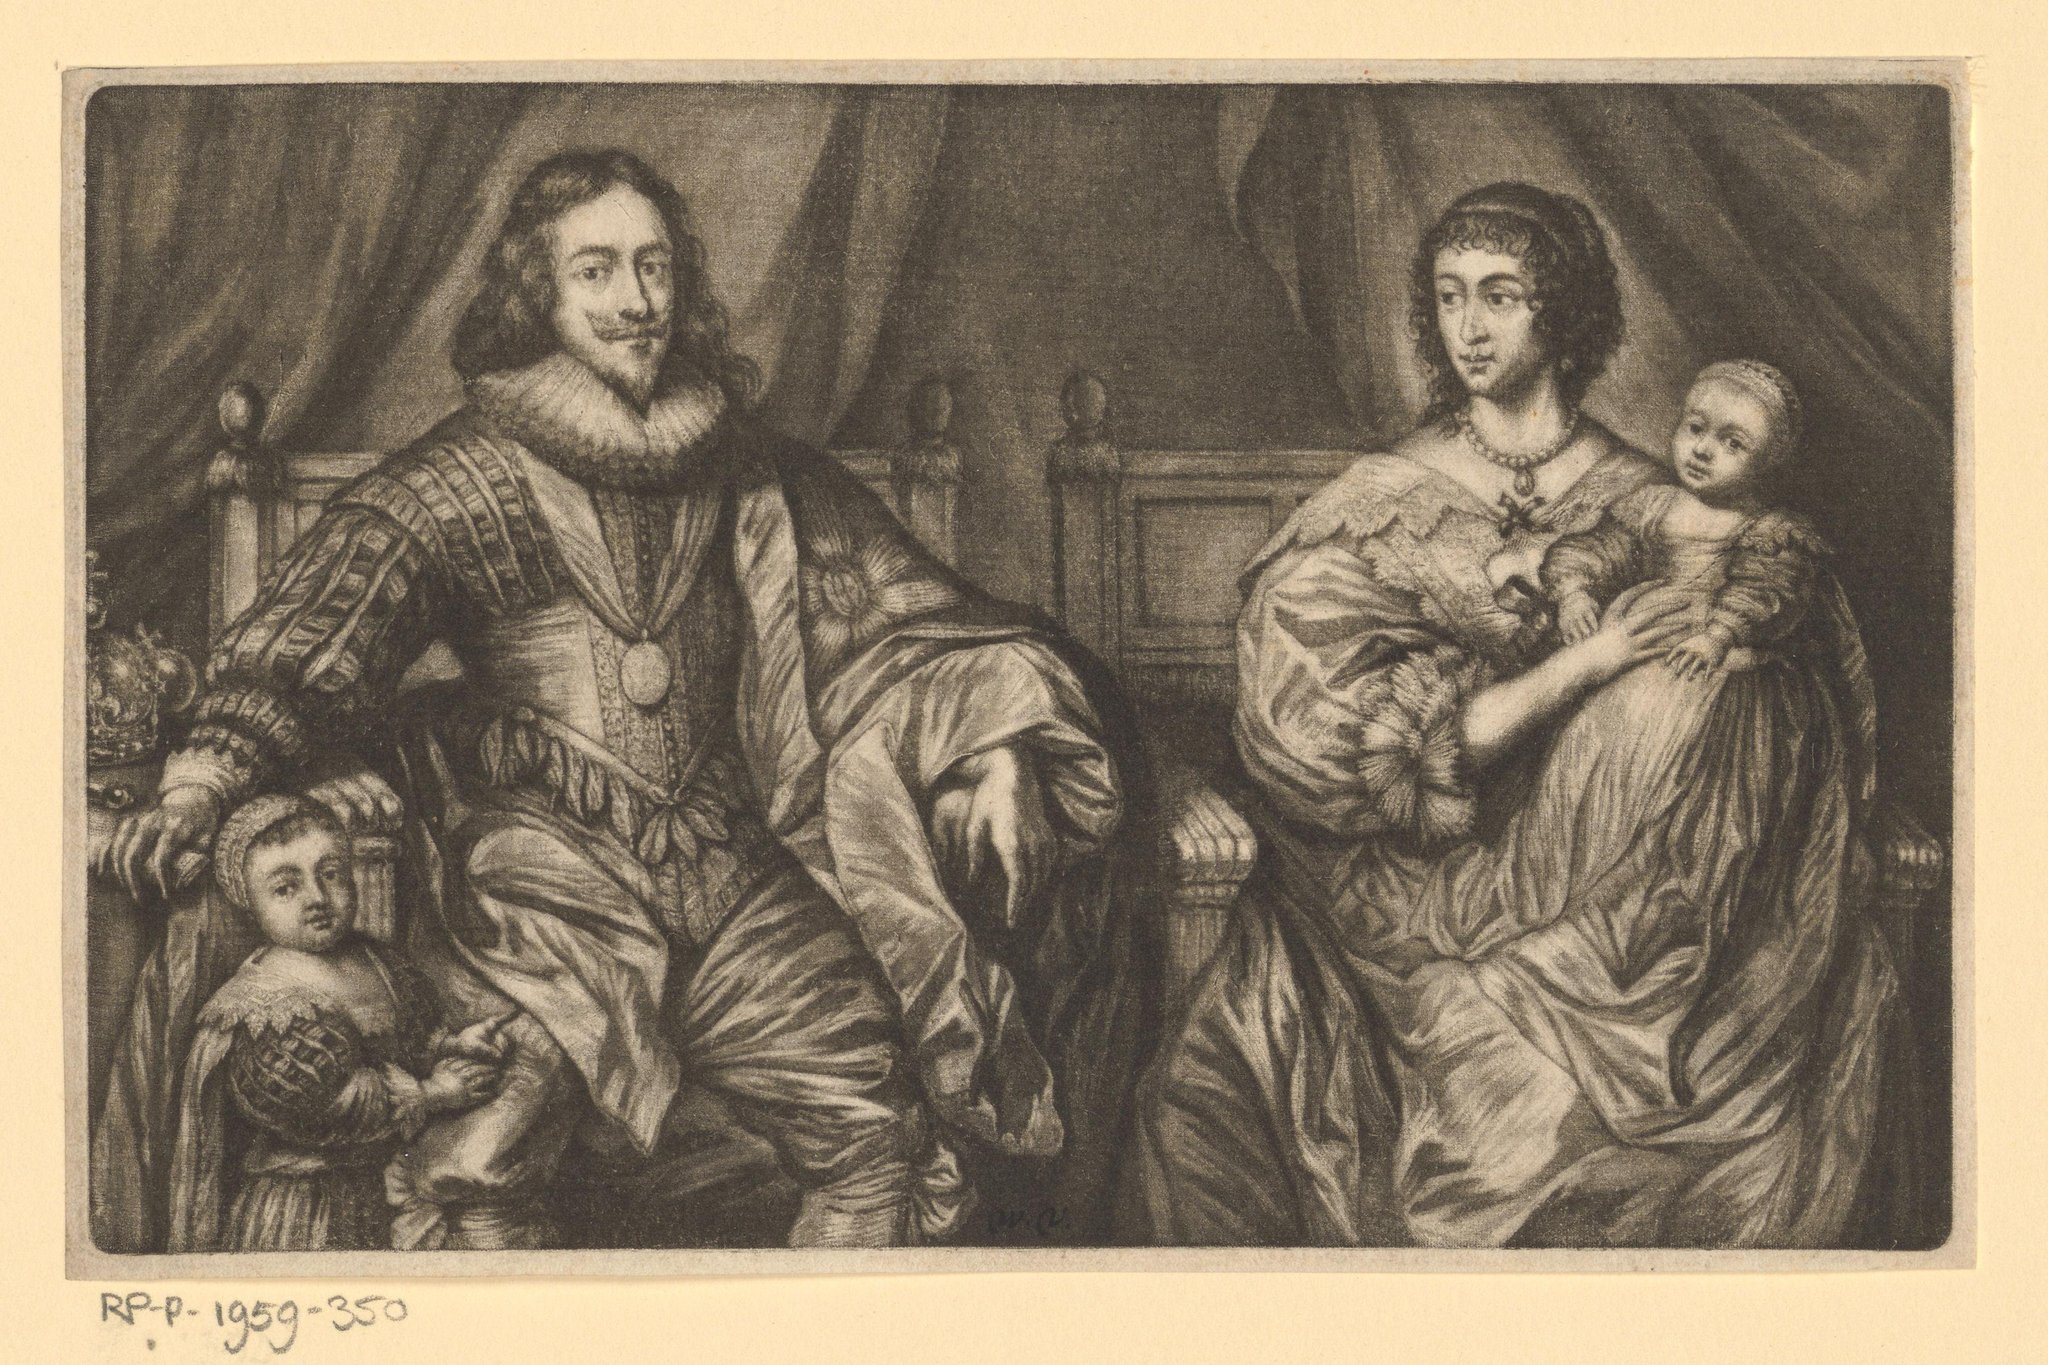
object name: print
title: Portret van Karel I, koning van Engeland en Henriëtta Maria van Frankrijk, koningin van Engeland, Schotland en Ierland met hun kinderen Karel II, koning van Engeland en Maria Henrietta Stuart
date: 1642-1677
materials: paper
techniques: mezzotint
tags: henriëtta maria van frankrijk (koningin van engeland, schotland en ierland), mary henrietta stuart, london, karel i (koning van engeland), karel ii (koning van engeland), historical persons - bb - woman, historical persons, queen, princess, king, crown prince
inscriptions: collector's mark: Lugt 2926, collector's mark: Lugt 4347